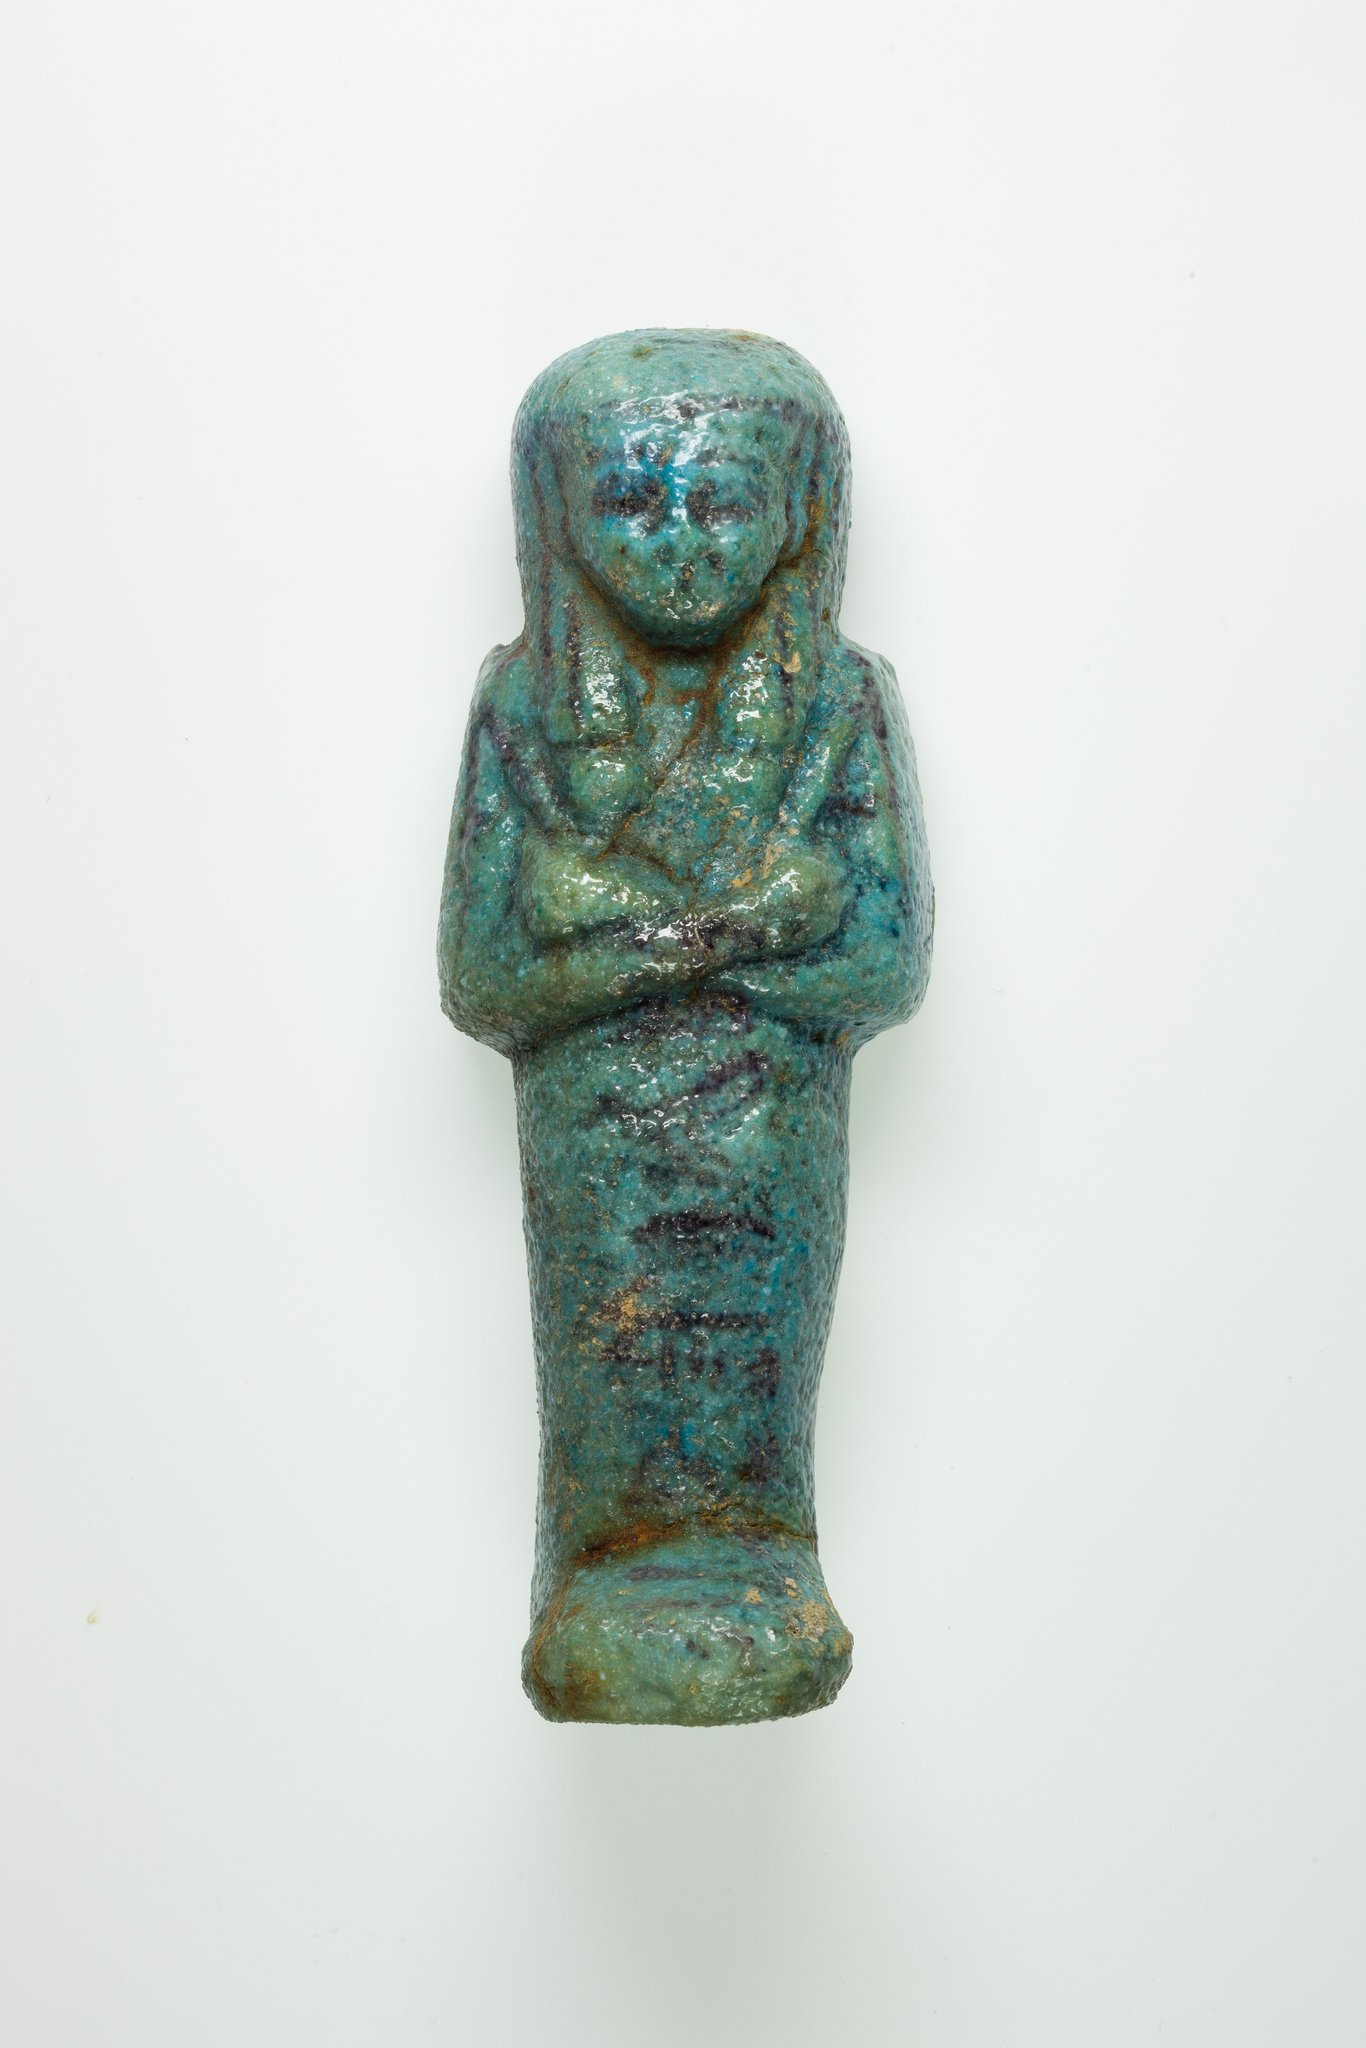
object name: worker shabti, henettawy c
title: Worker Shabti of Henettawy (C), Daughter of Isetemkheb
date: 990-970 BCE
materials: faience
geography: egypt